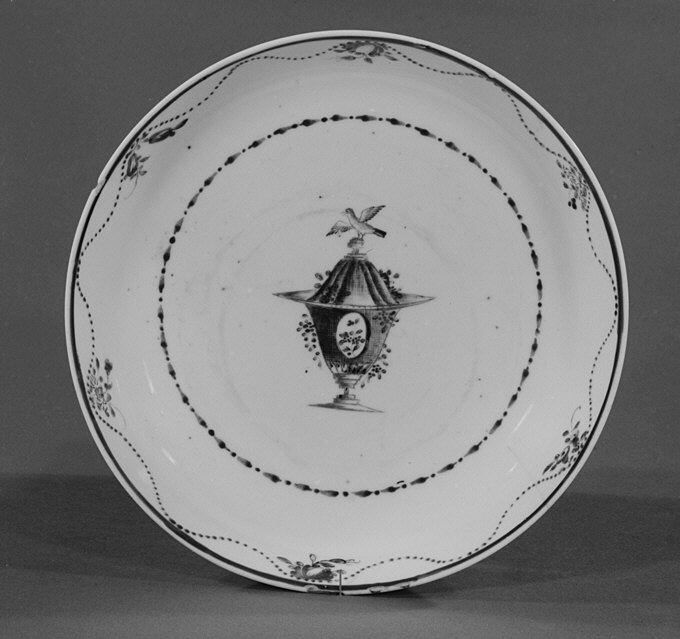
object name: dish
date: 1790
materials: hard paste porcelain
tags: birds